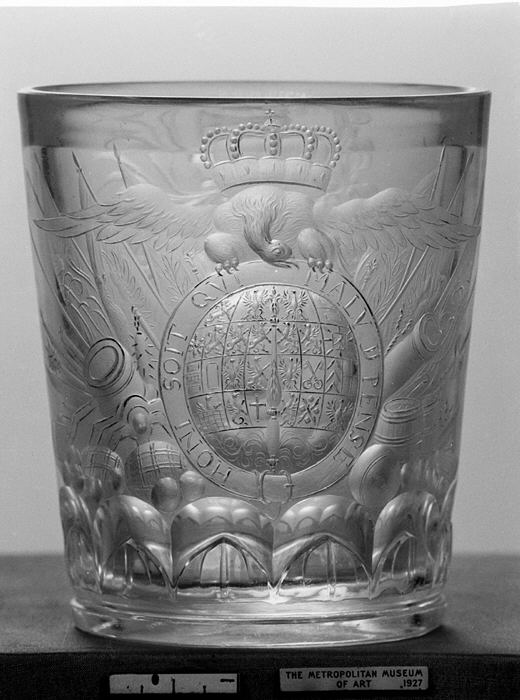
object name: beaker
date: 1688-1700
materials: glass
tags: eagles,coat of arms